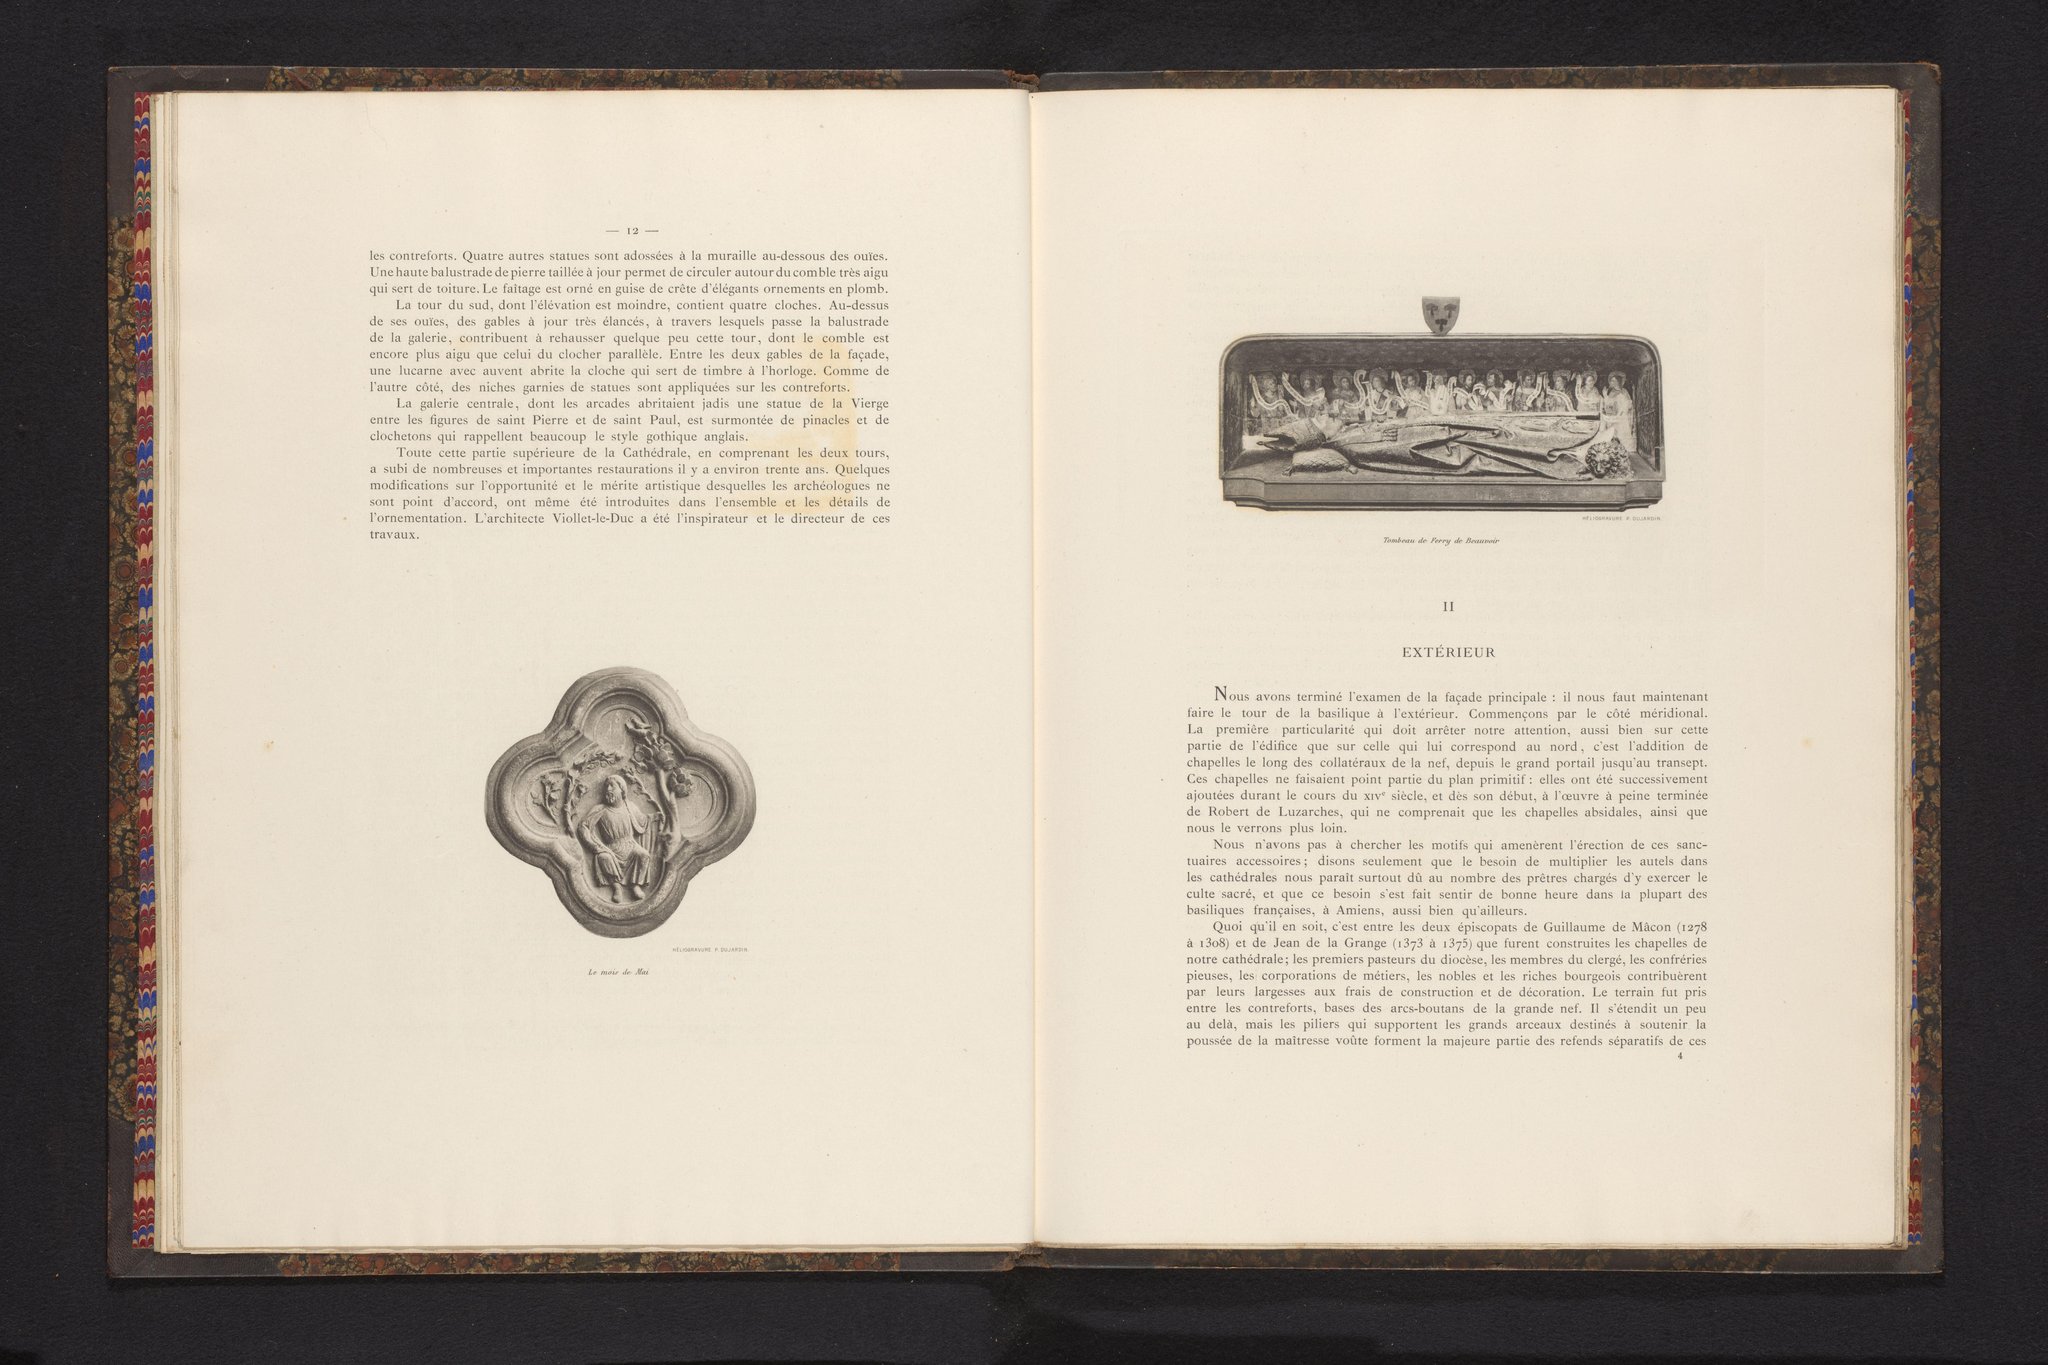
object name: photomechanical print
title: Grafmonument van Ferry de Beauvoir in de Notre-Dame van Amiens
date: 1888-1893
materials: paper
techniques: photograph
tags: grave-building, monumental tomb, notre-dame d'amiens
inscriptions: inscription: ‘Tombeau de Ferry de Beauvoir’